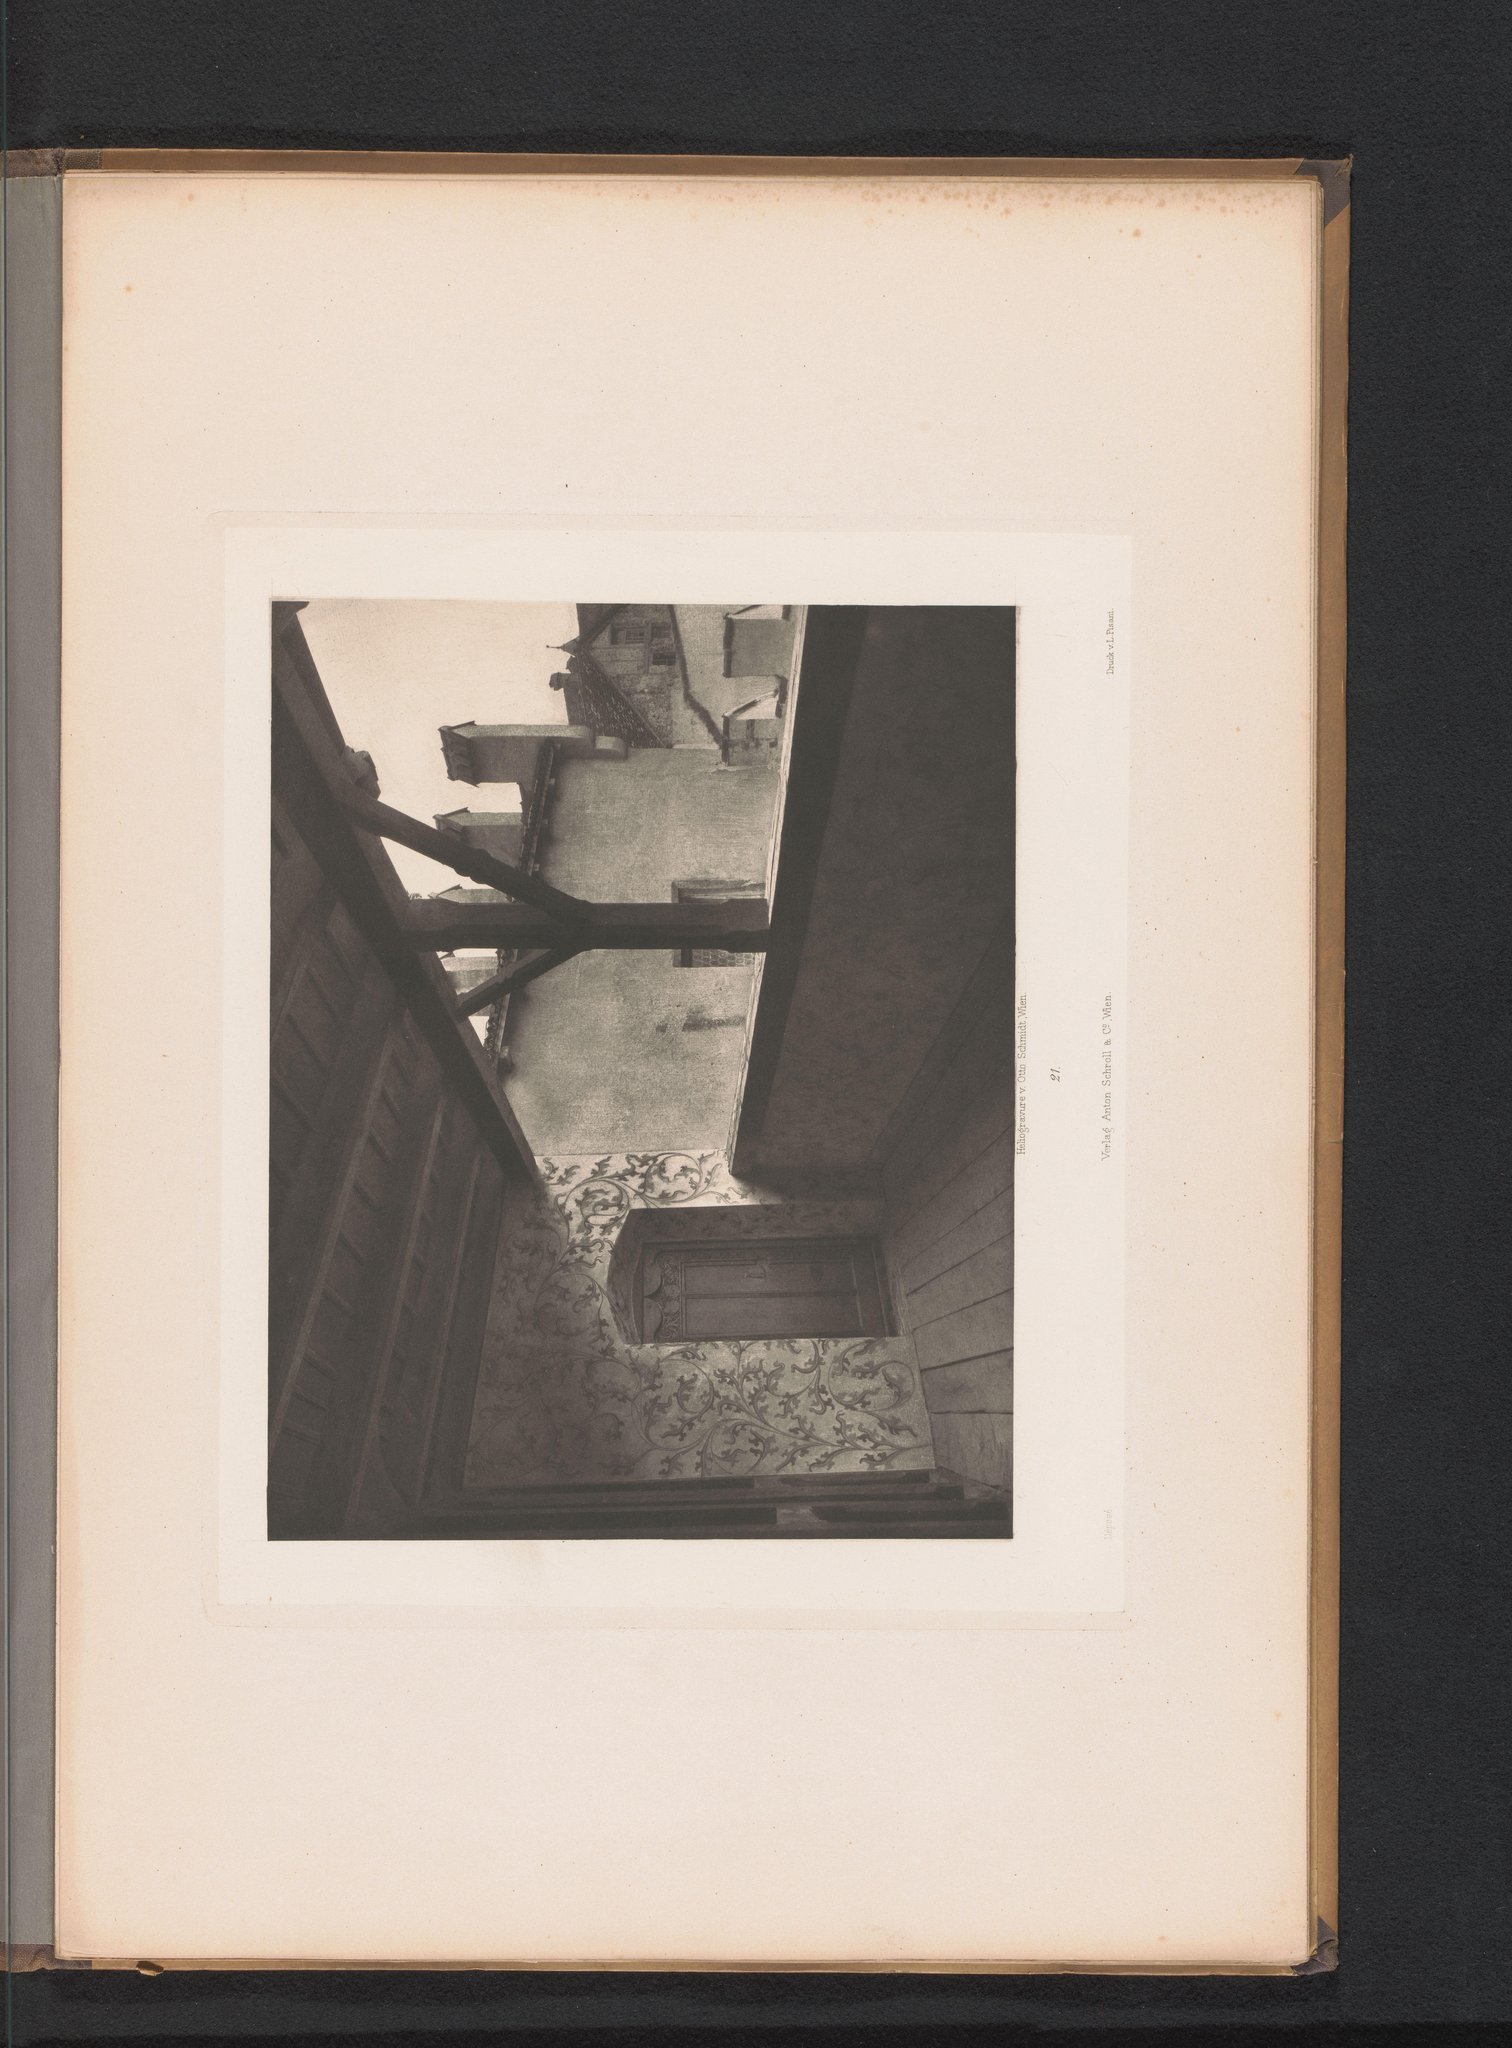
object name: photomechanical print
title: Overloop met wandschildering van de Vorstenburcht in Merano, Italië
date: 1886-1891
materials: paper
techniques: photoaquatint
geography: merano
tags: castle - aa - civic architecture: inside, gallery (spacious corridor), picture, painting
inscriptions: number: ‘21.’, inscription: ‘Déposé.’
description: Deze prent maakt deel uit van een omslag met dertig prenten en drie tekstbladen.